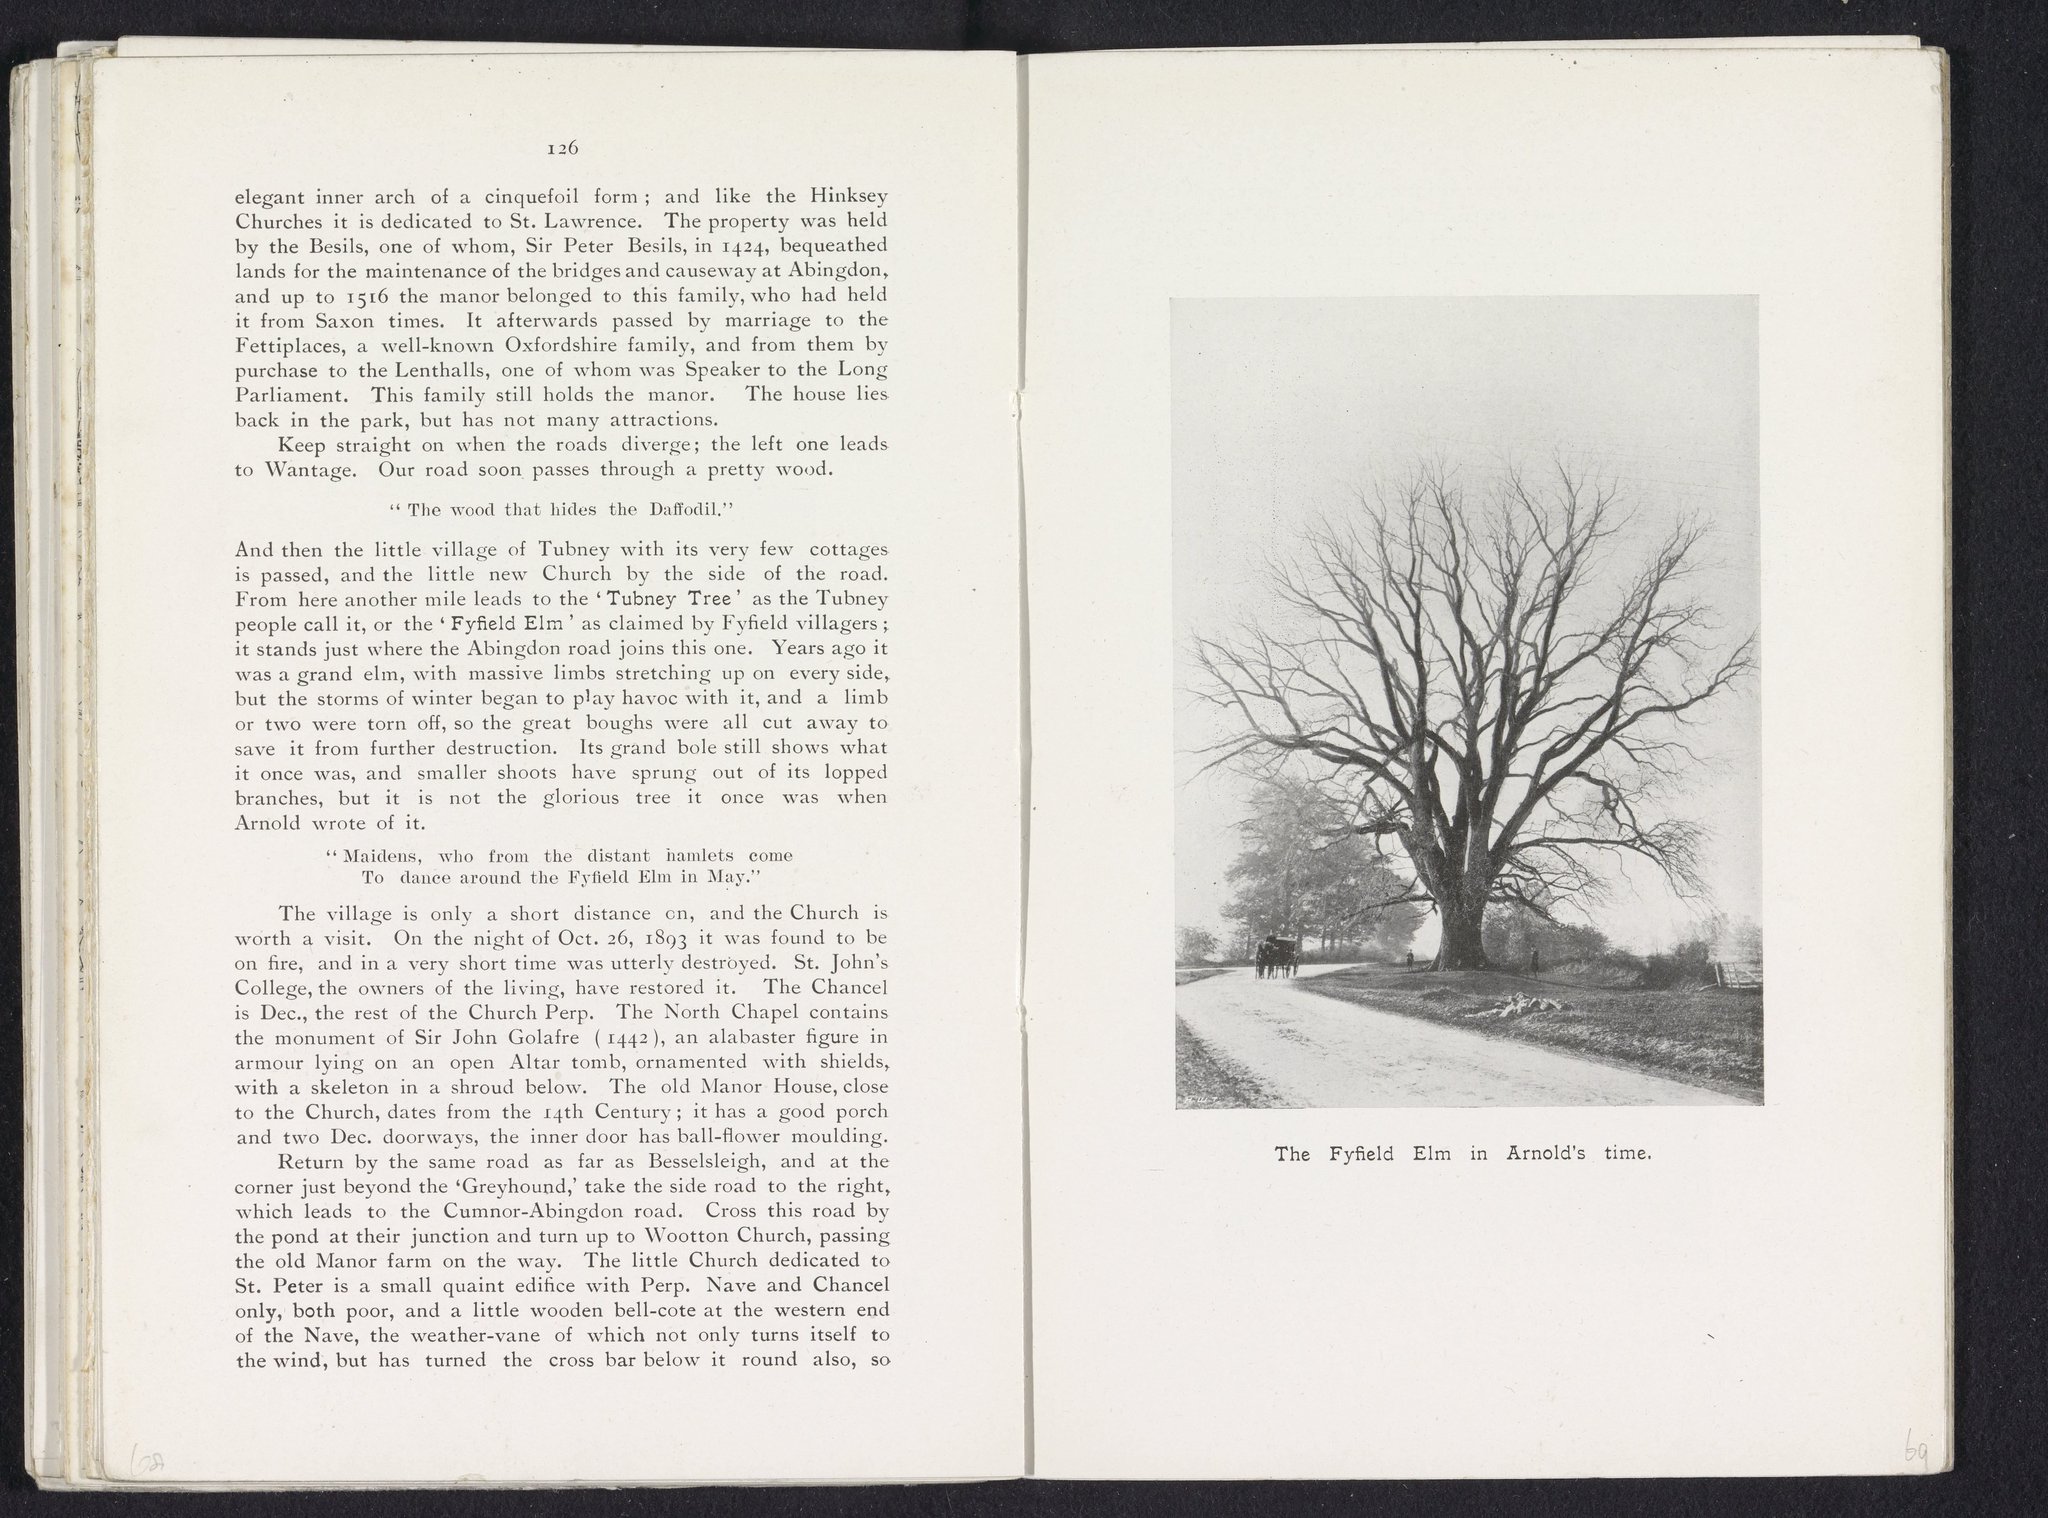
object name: page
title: The Fyfield Elm in Arnold's time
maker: henry w. taunt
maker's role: fotograaf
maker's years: 1842-1922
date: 1907-1912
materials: paper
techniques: autotype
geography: fyfield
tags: trees: elm